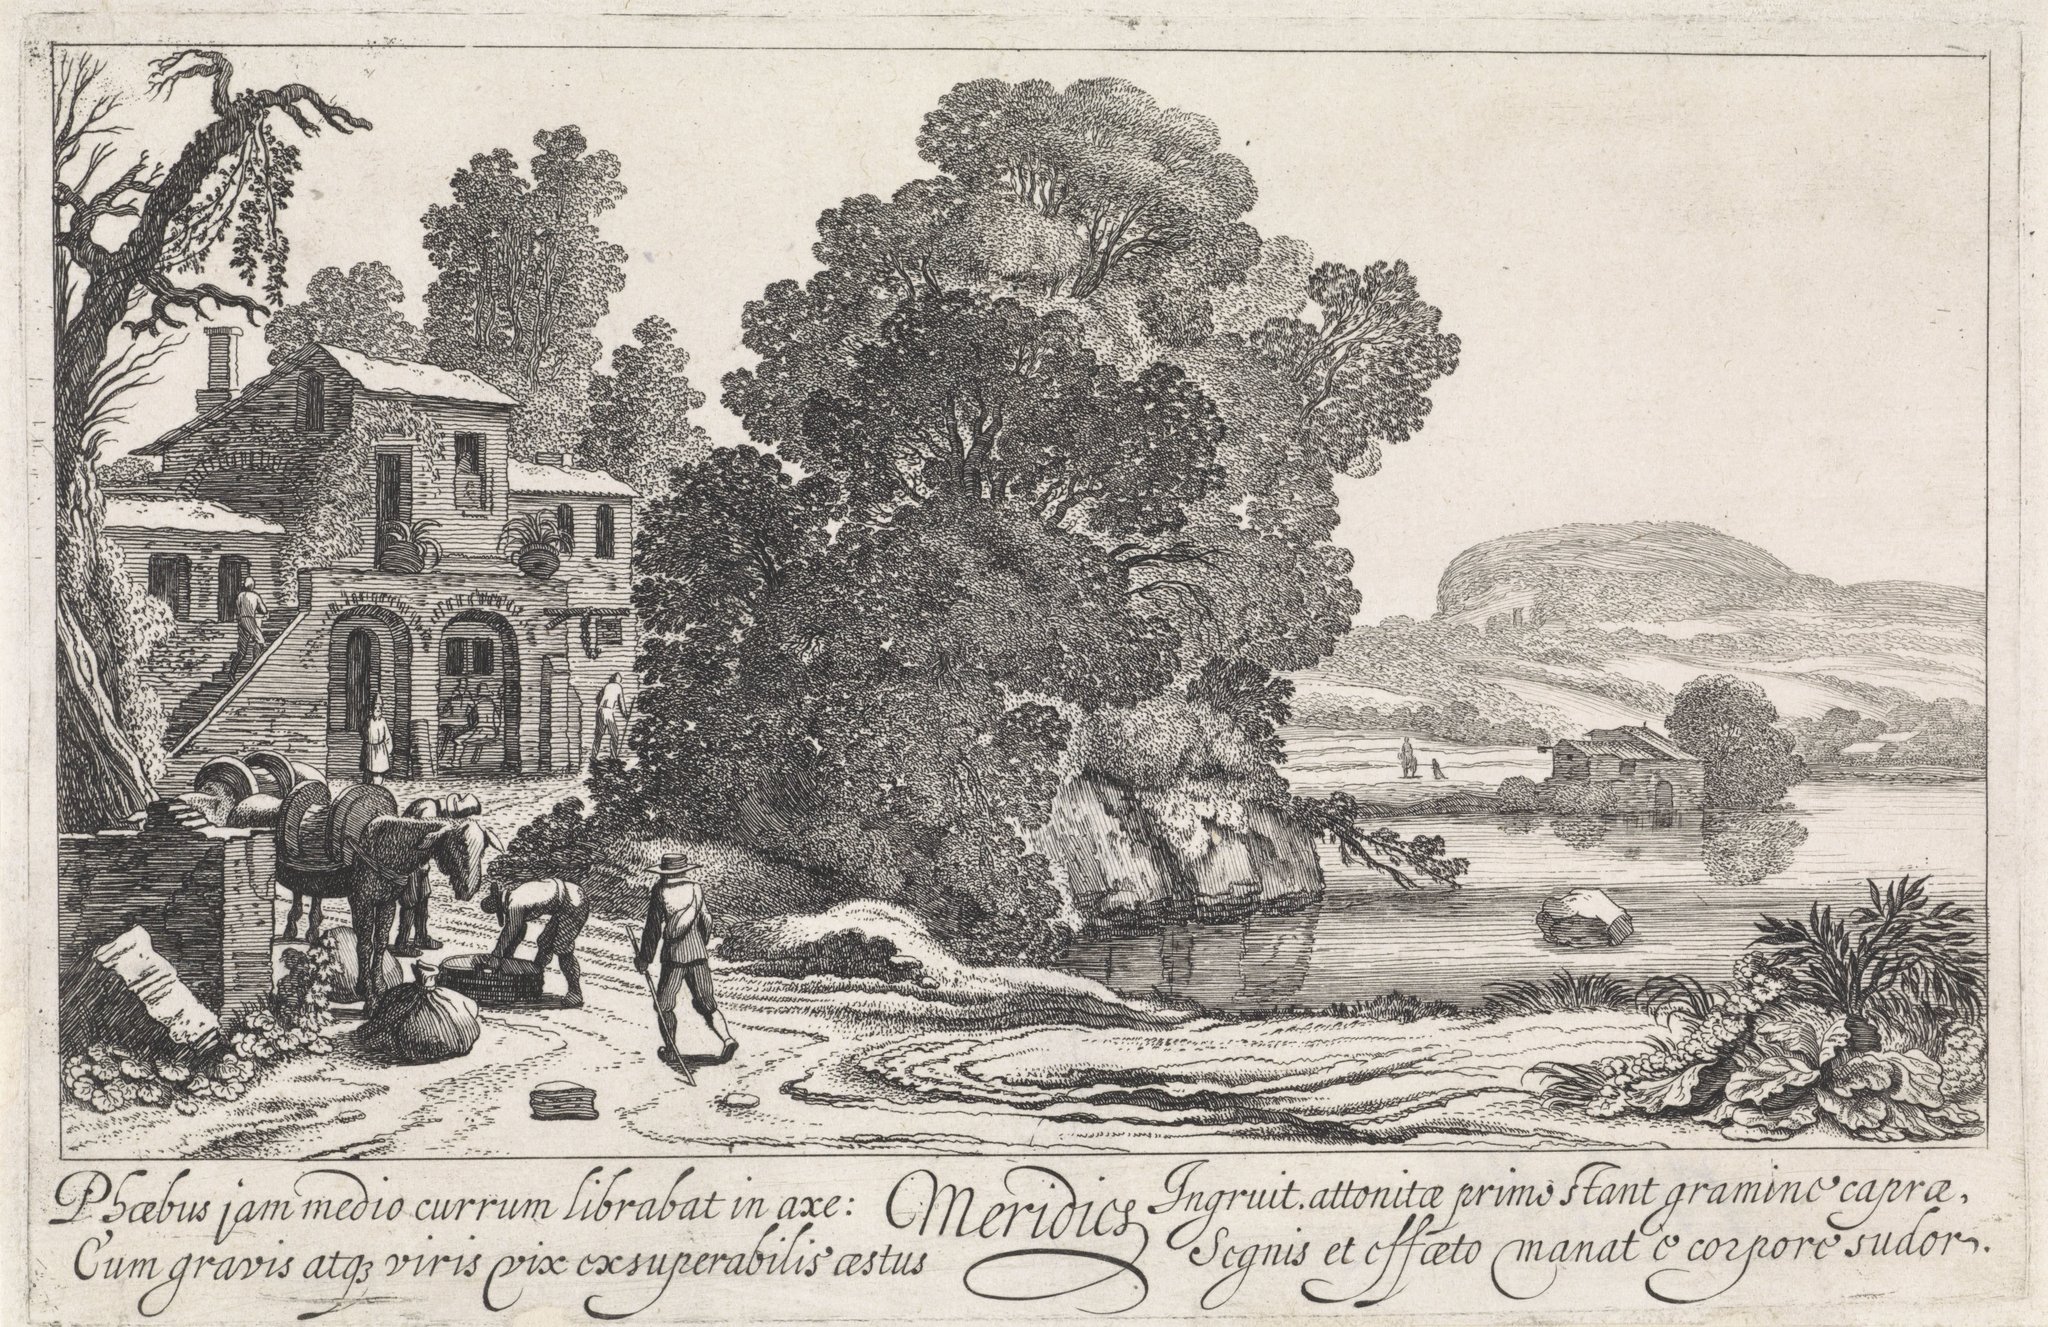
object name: print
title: Italianiserend landschap: middag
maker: jan van de velde (ii)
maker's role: draughtsman, painter, print maker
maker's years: 1593-1641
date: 1603-1641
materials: paper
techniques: etching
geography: northern netherlands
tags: pack-animal, lake, afternoon ~ landscape (sometimes titled 'meridies'), farm or solitary house in landscape (+ city(-scape) with figures, staffage)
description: Gezicht op een Italianiserend landschap met een meer en figuren bij een huis, voorstellende de middag. Linksvoor twee figuren bij pakezels. Prent uit een serie van vier.